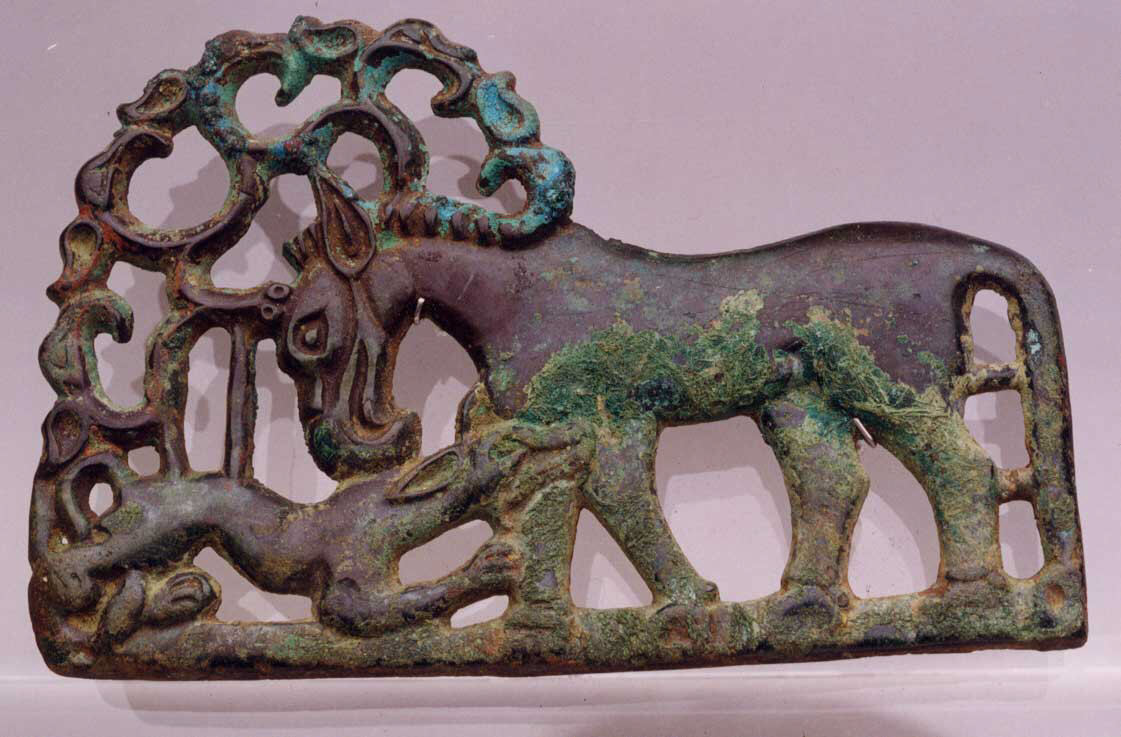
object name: belt buckle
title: Belt Buckle with Animal-Combat Scene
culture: north chinese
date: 300-101 BCE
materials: bronze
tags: animals